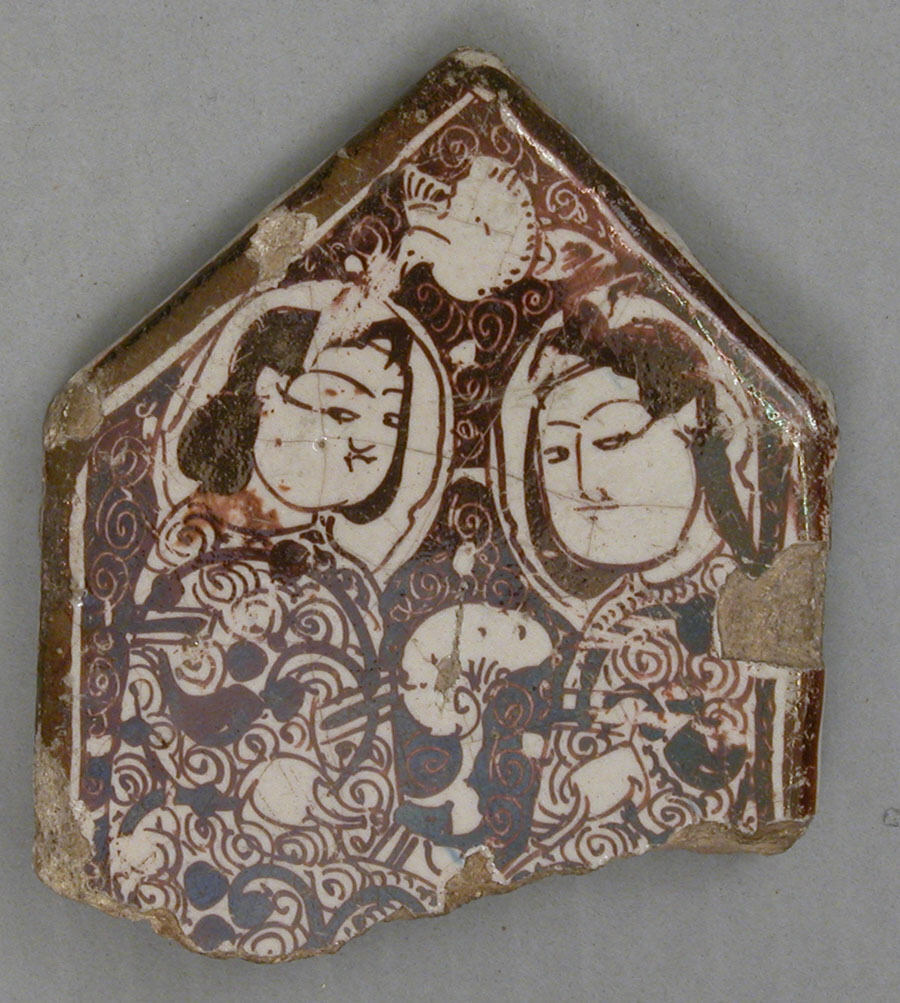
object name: tile fragment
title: Cross-Shaped Tile Fragment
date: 1201-1250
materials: stonepaste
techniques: luster painting, overglaze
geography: iran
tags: human figures